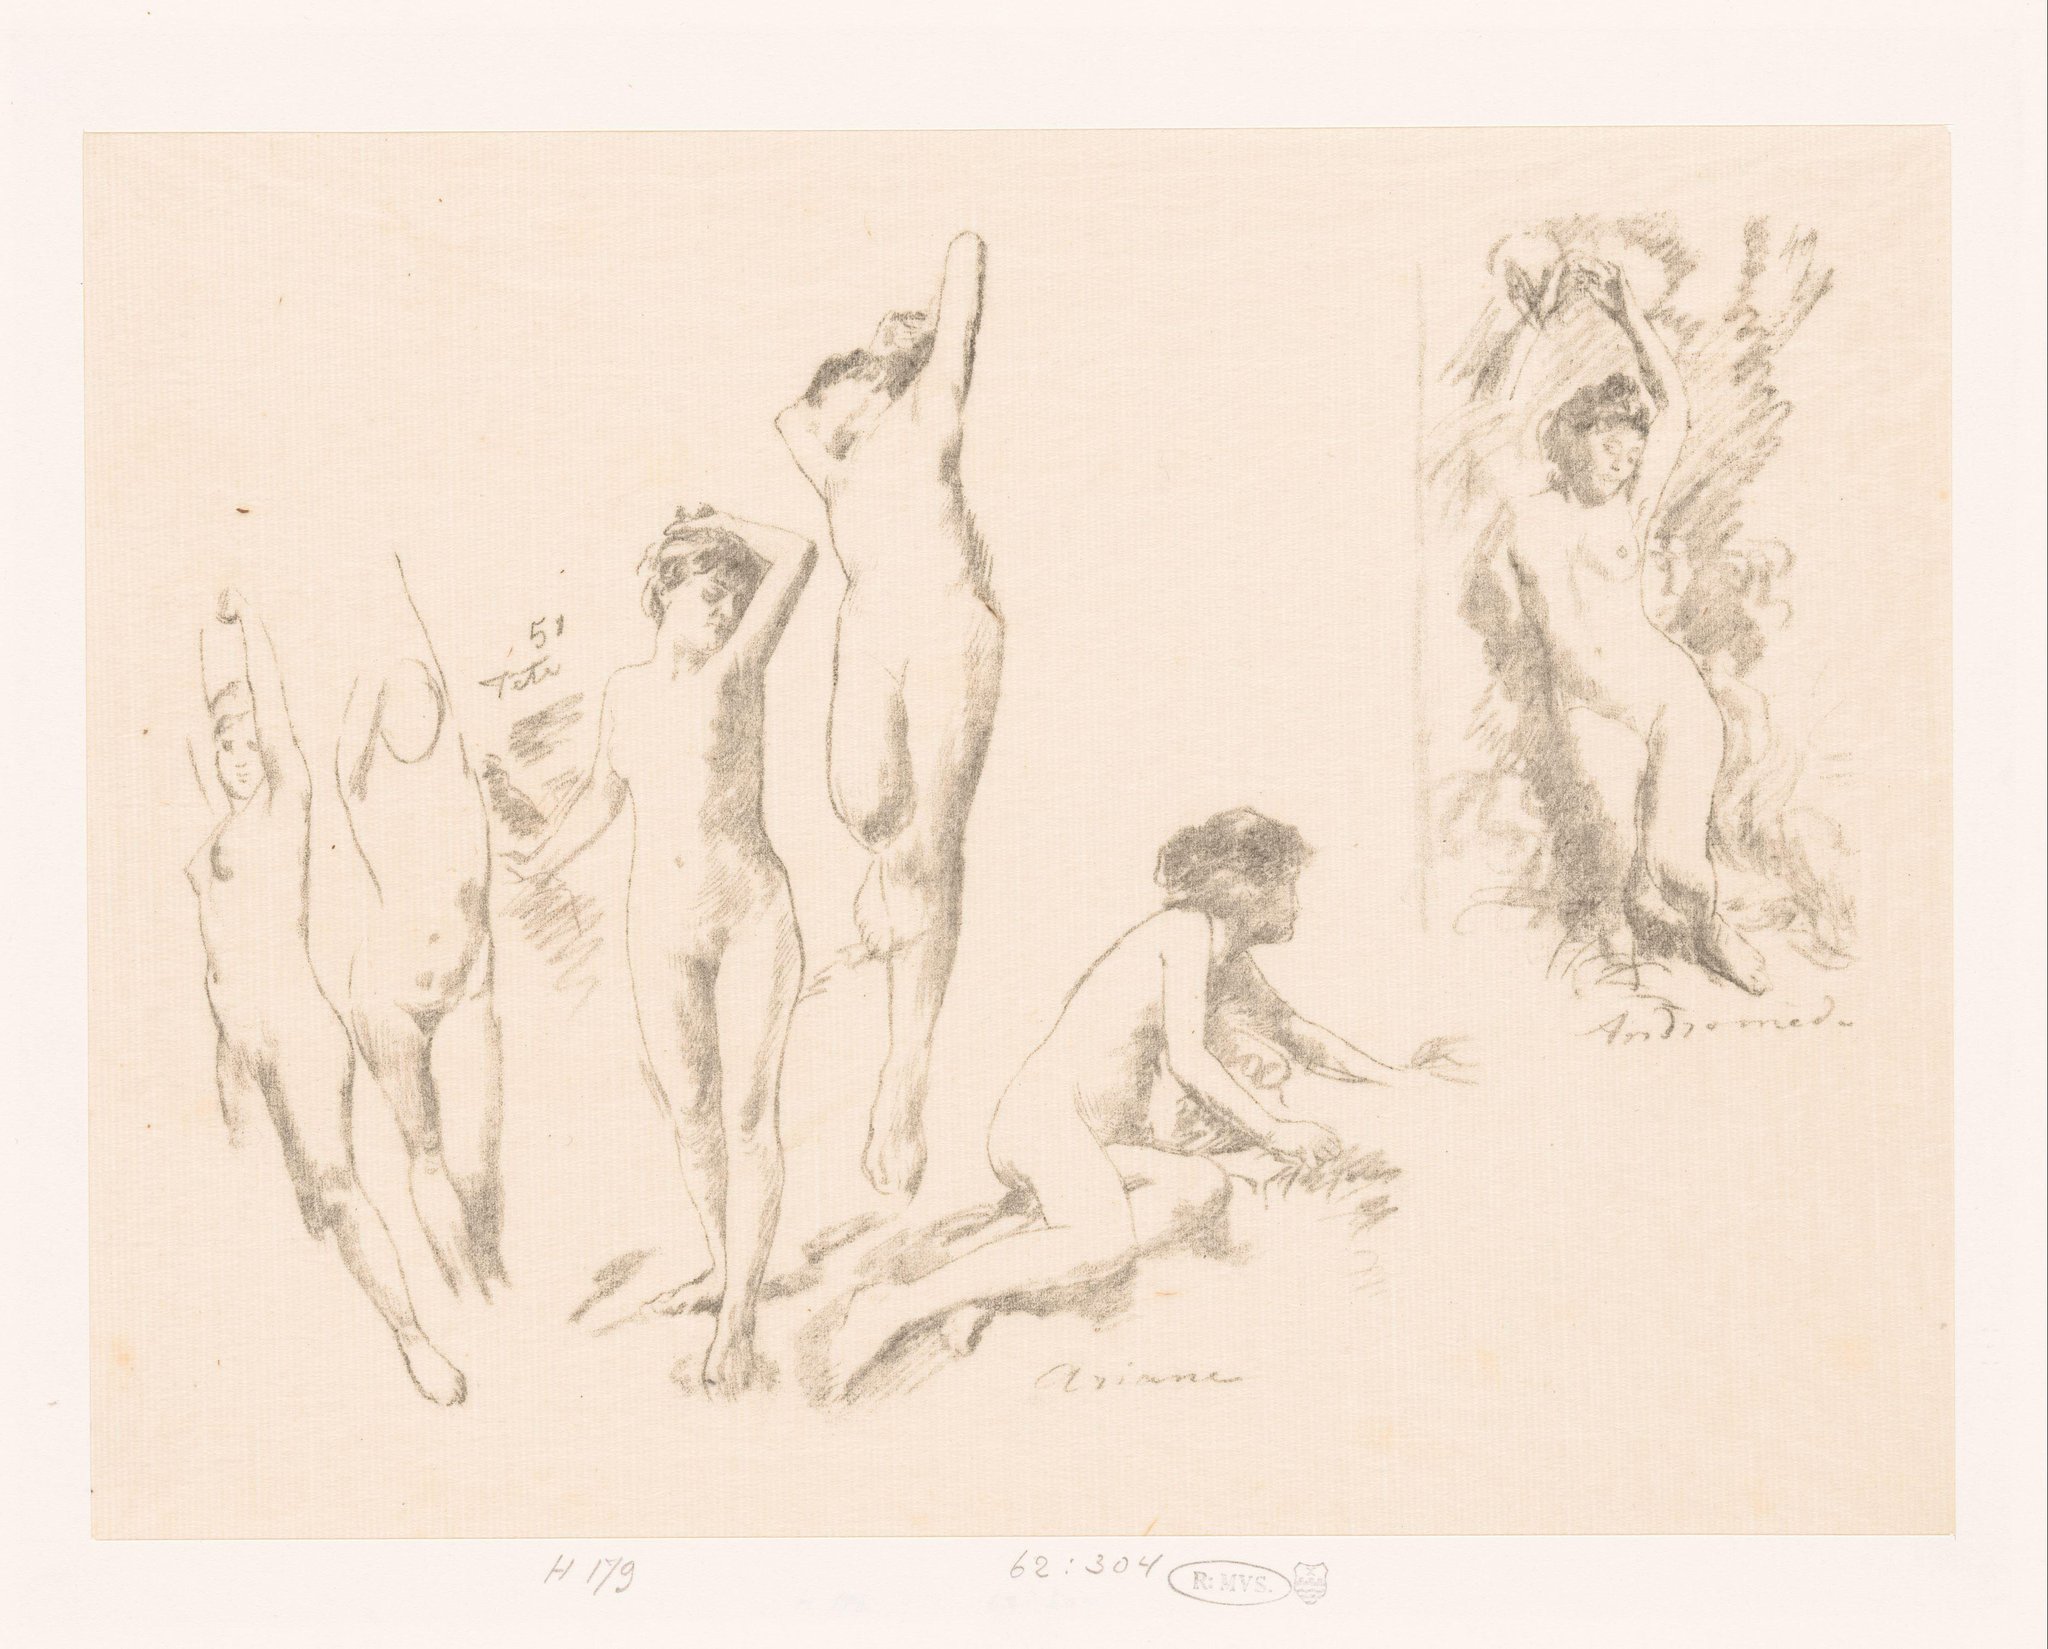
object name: print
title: Studieblad met zes naakte vrouwen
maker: henri fantin-latour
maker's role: draughtsman, print maker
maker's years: 1836-1904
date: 1903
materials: paper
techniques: lithography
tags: the (nude) human figure; 'corpo humano' (ripa) - aa - female human figure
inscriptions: collector's mark: Lugt 2760, annotation: ‘51 Tête/ Ariane/ Andromeda’, collector's mark: Lugt 2228a